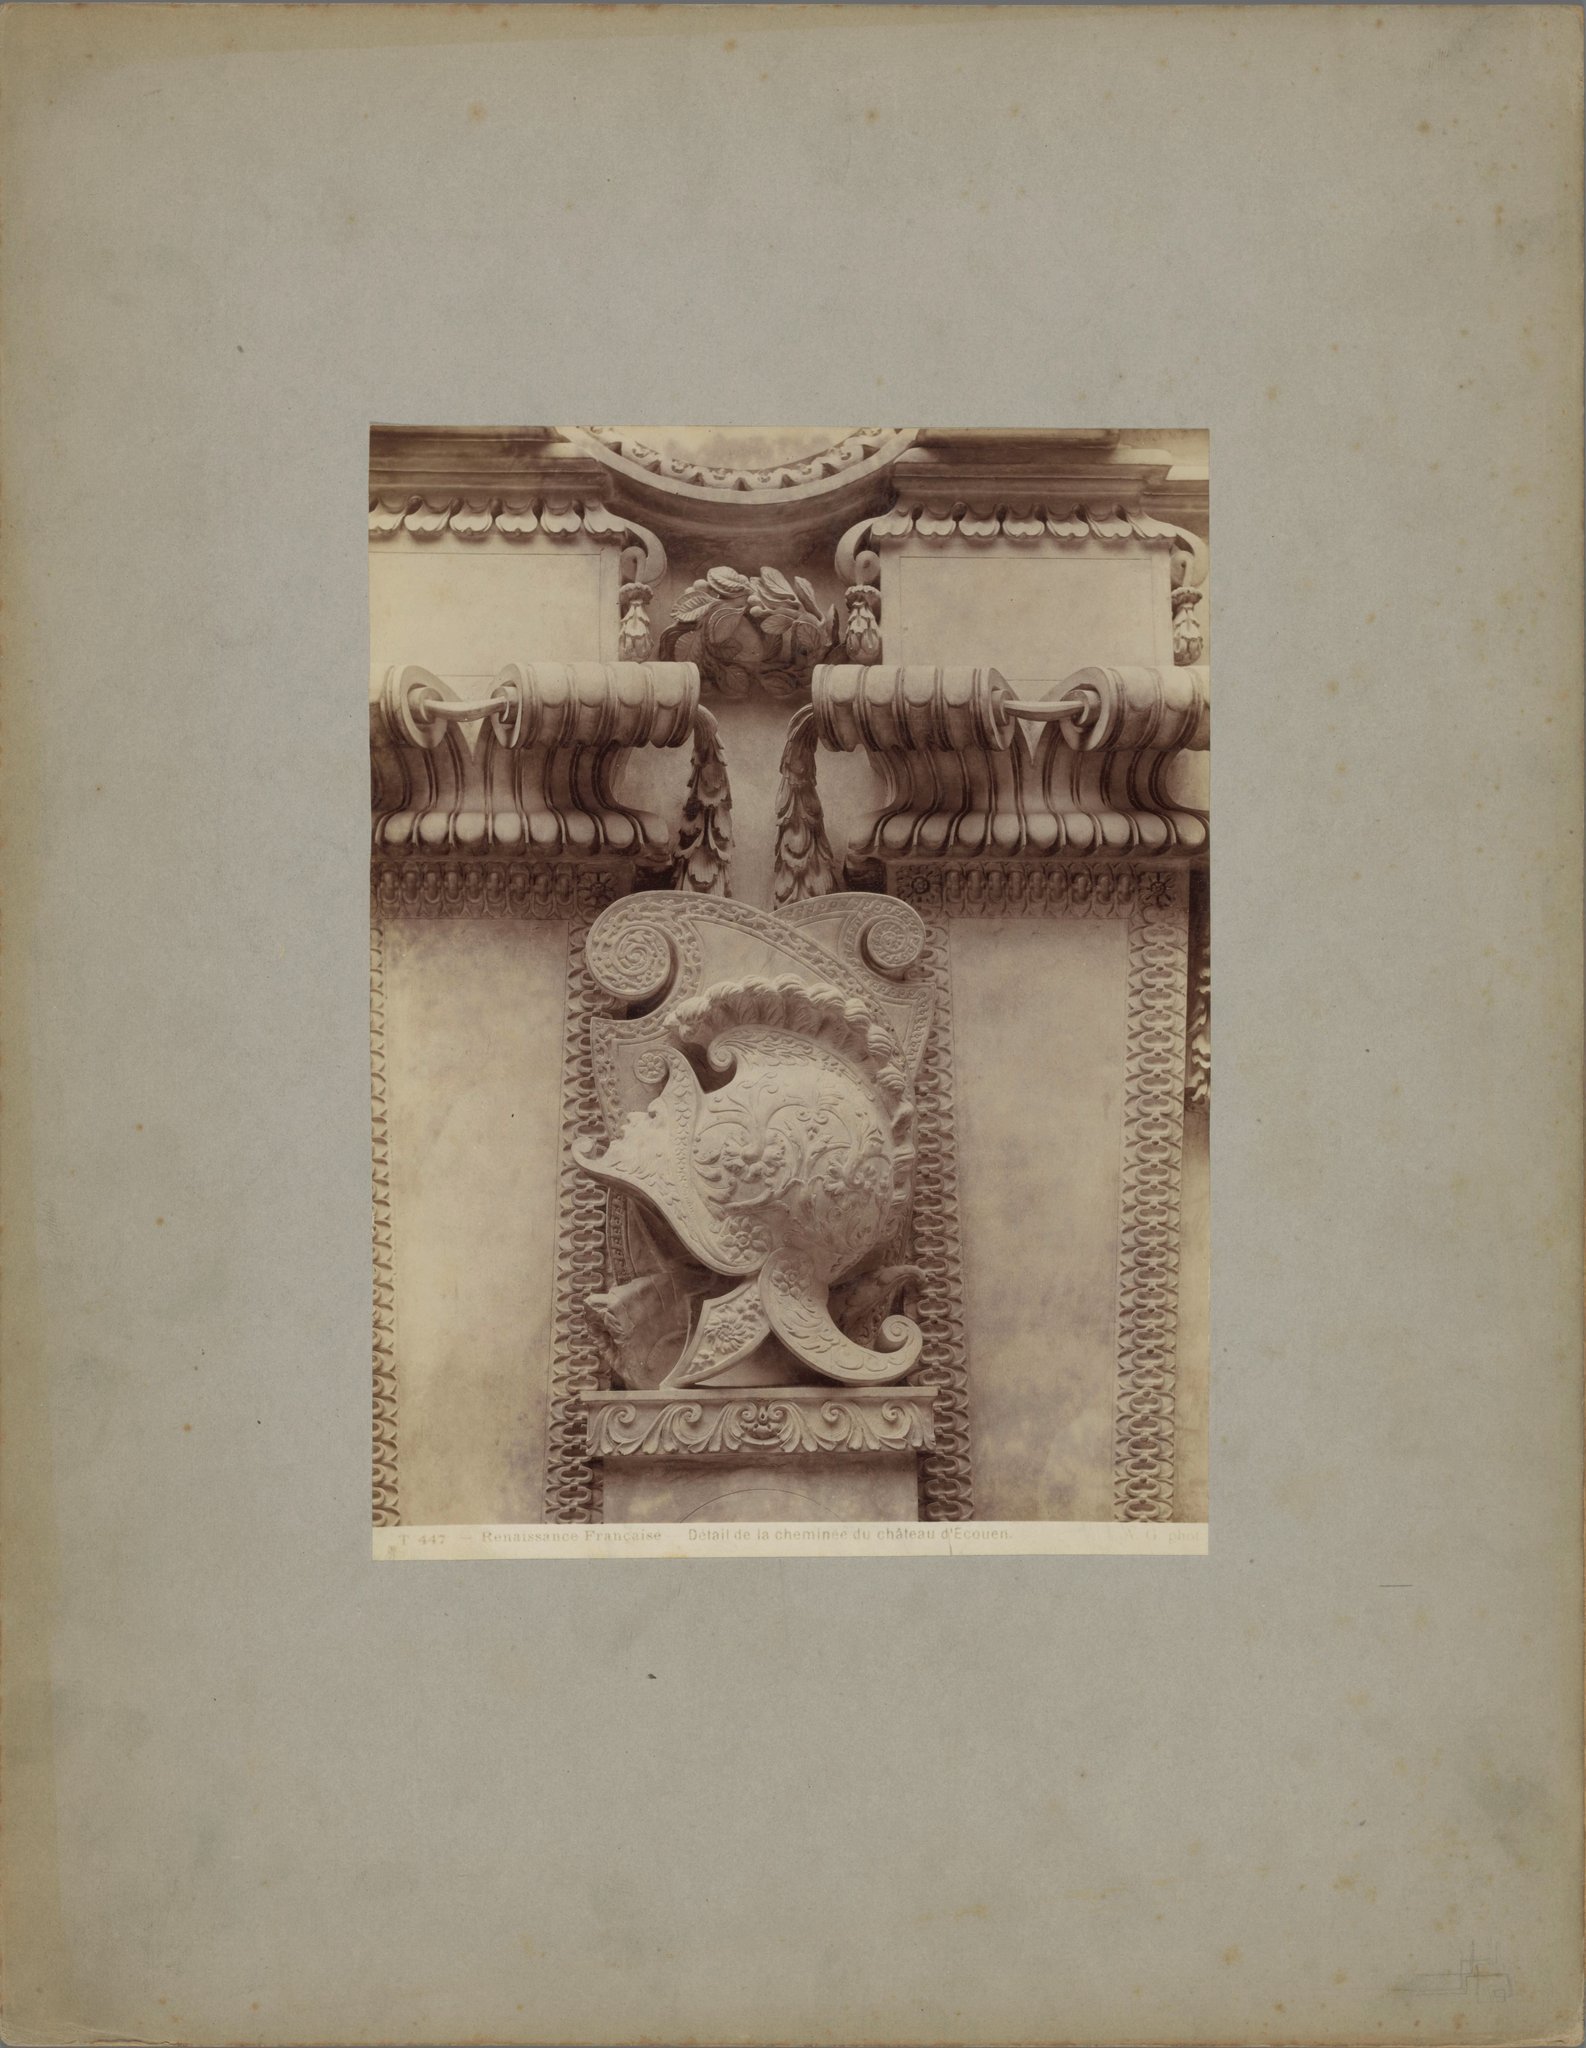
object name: photograph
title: Open haard afkomstig uit Château d'Écouen gedecoreerd met helmen en een vrouw met een zwaard en een lauwerkrans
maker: adolphe giraudon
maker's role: publisher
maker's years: 1849-1929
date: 1875-1900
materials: cardboard, photographic support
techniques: albumen print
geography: europe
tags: helmet, open hearth, fire-place, sculpture (+ relief ~ sculpture)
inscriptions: name: ‘A. GIRAUDON EDITEUR 15. R [...] PARIS’, collector's mark: Lugt 3937, number: ‘T 446’